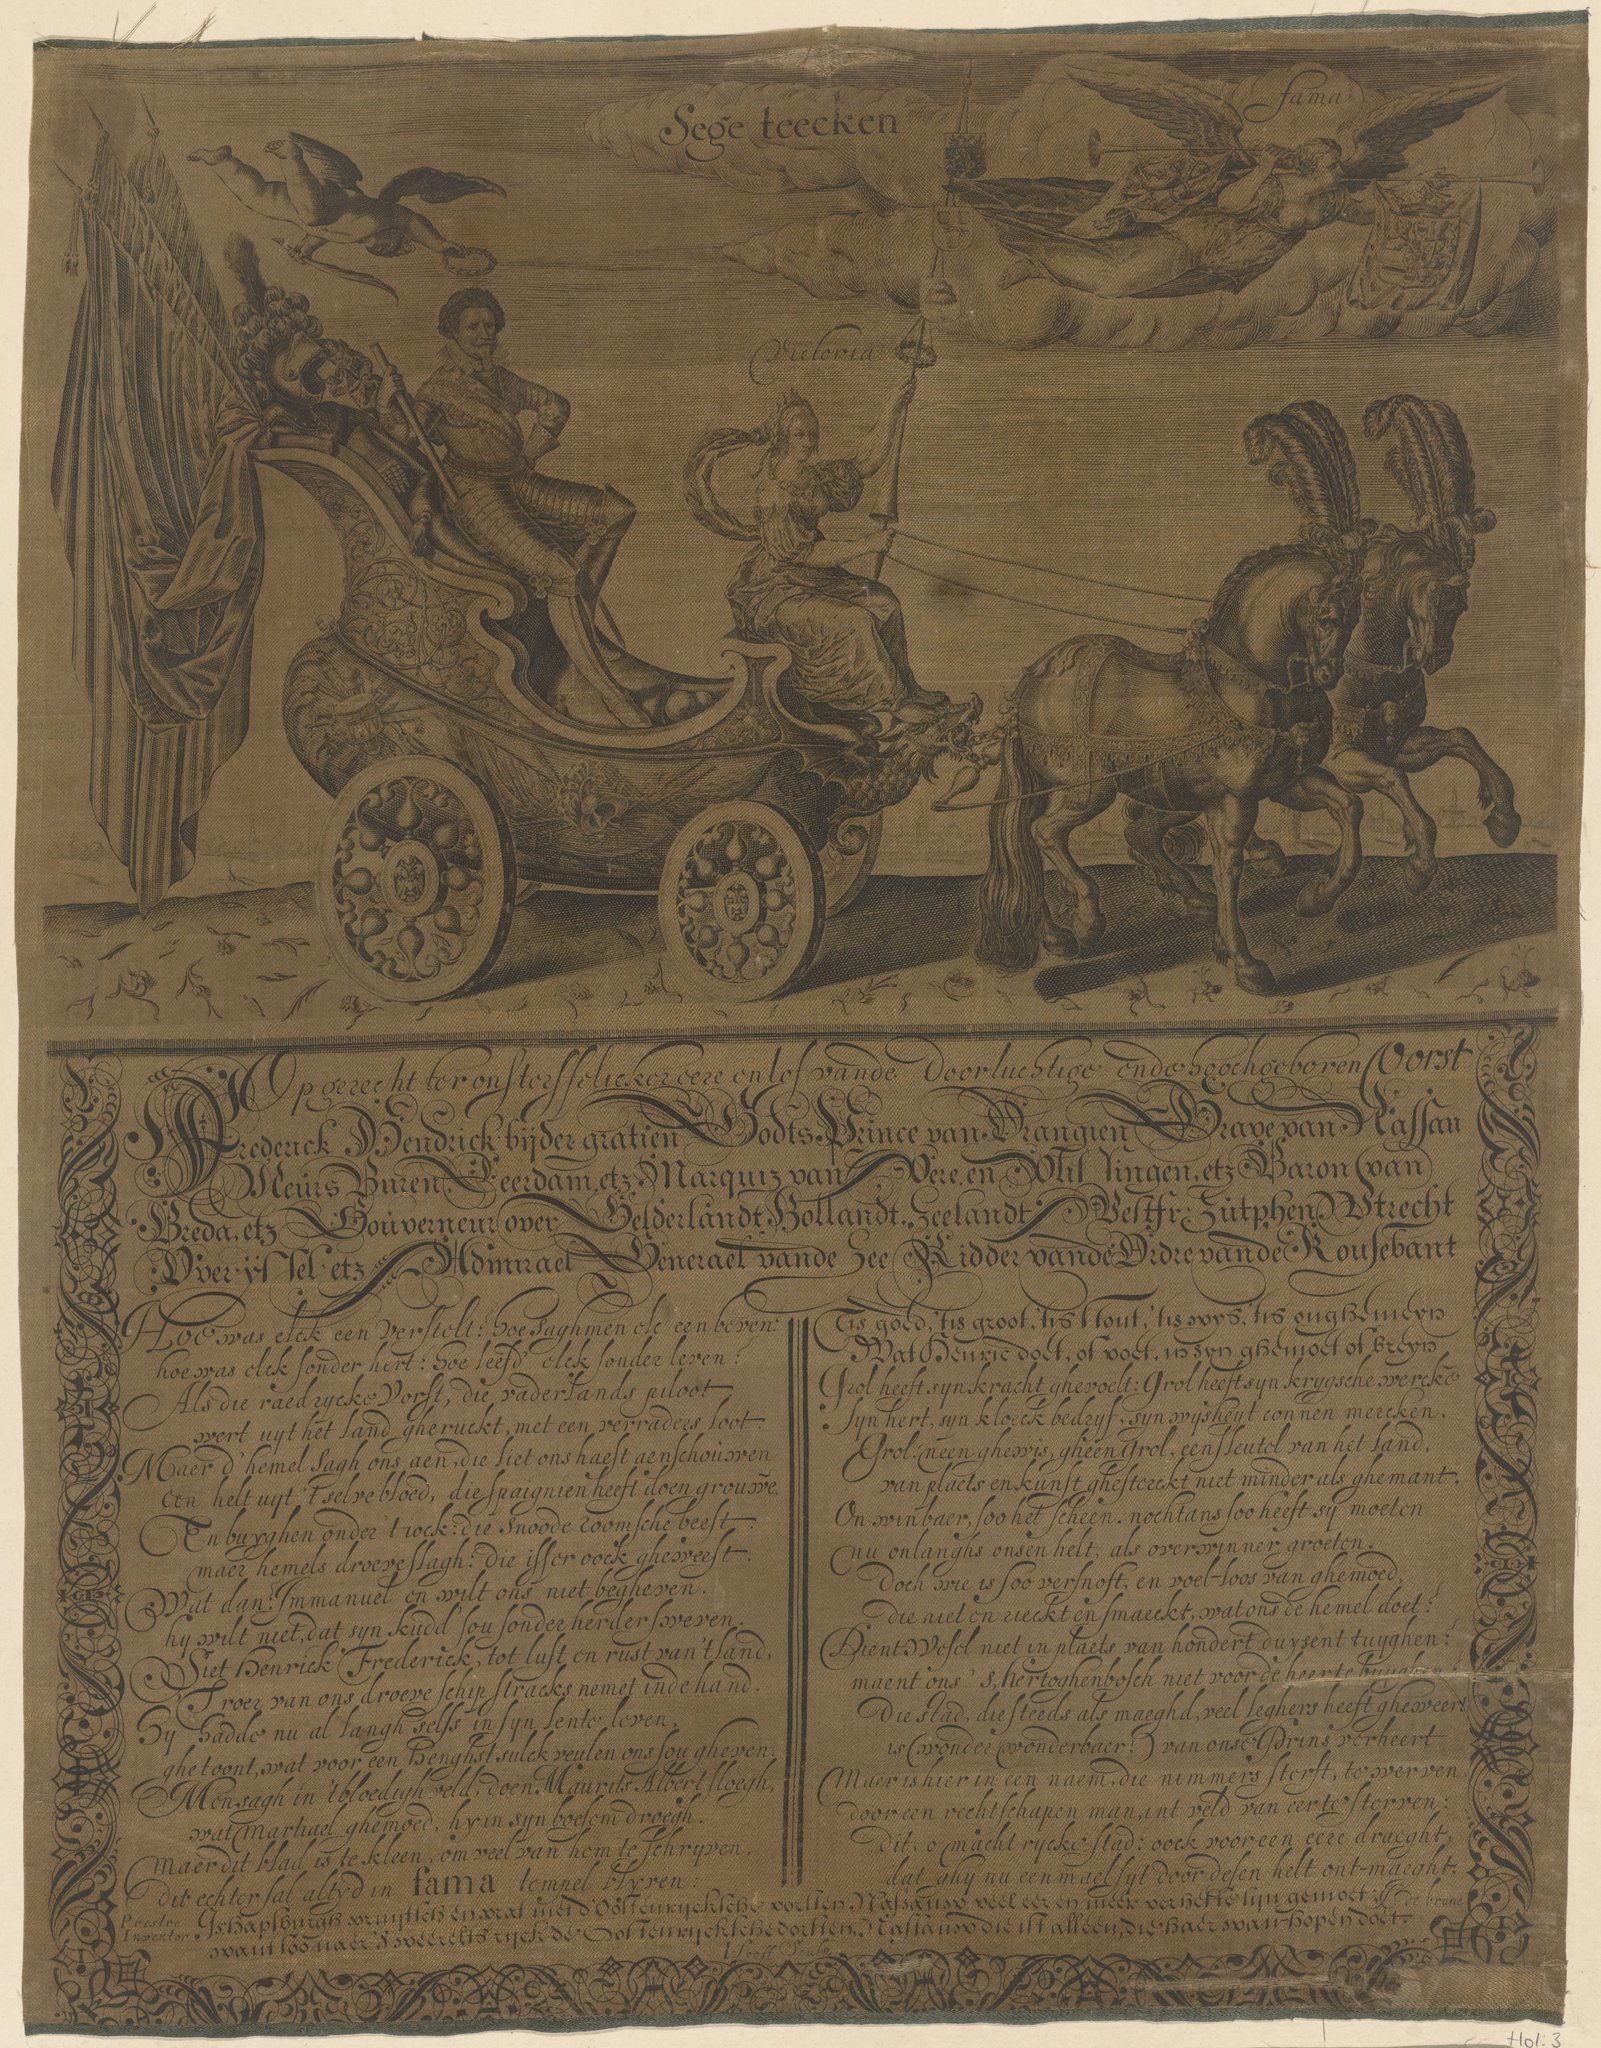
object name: print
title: Frederik Hendrik op een triomfwagen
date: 1627-1651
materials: silk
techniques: engraving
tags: frederick henry (prince of orange), victoria as roman personification, symbolic triumphs of individual persons, fame; 'fama', 'fama buona', 'fama chiara' (ripa), crowning the victor with laurel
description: Frederik Hendrik, prins van Oranje-Nassau, wordt door twee paarden op een triomfwagen voortgetrokken en door een engel gelauwerd. Voorop de wagen zit Victoria, de personificatie van de overwinning. Rechts in de lucht blaast de Faam een bazuin. Met gekalligrafeerd Nederlands lofdicht in twee kolommen.